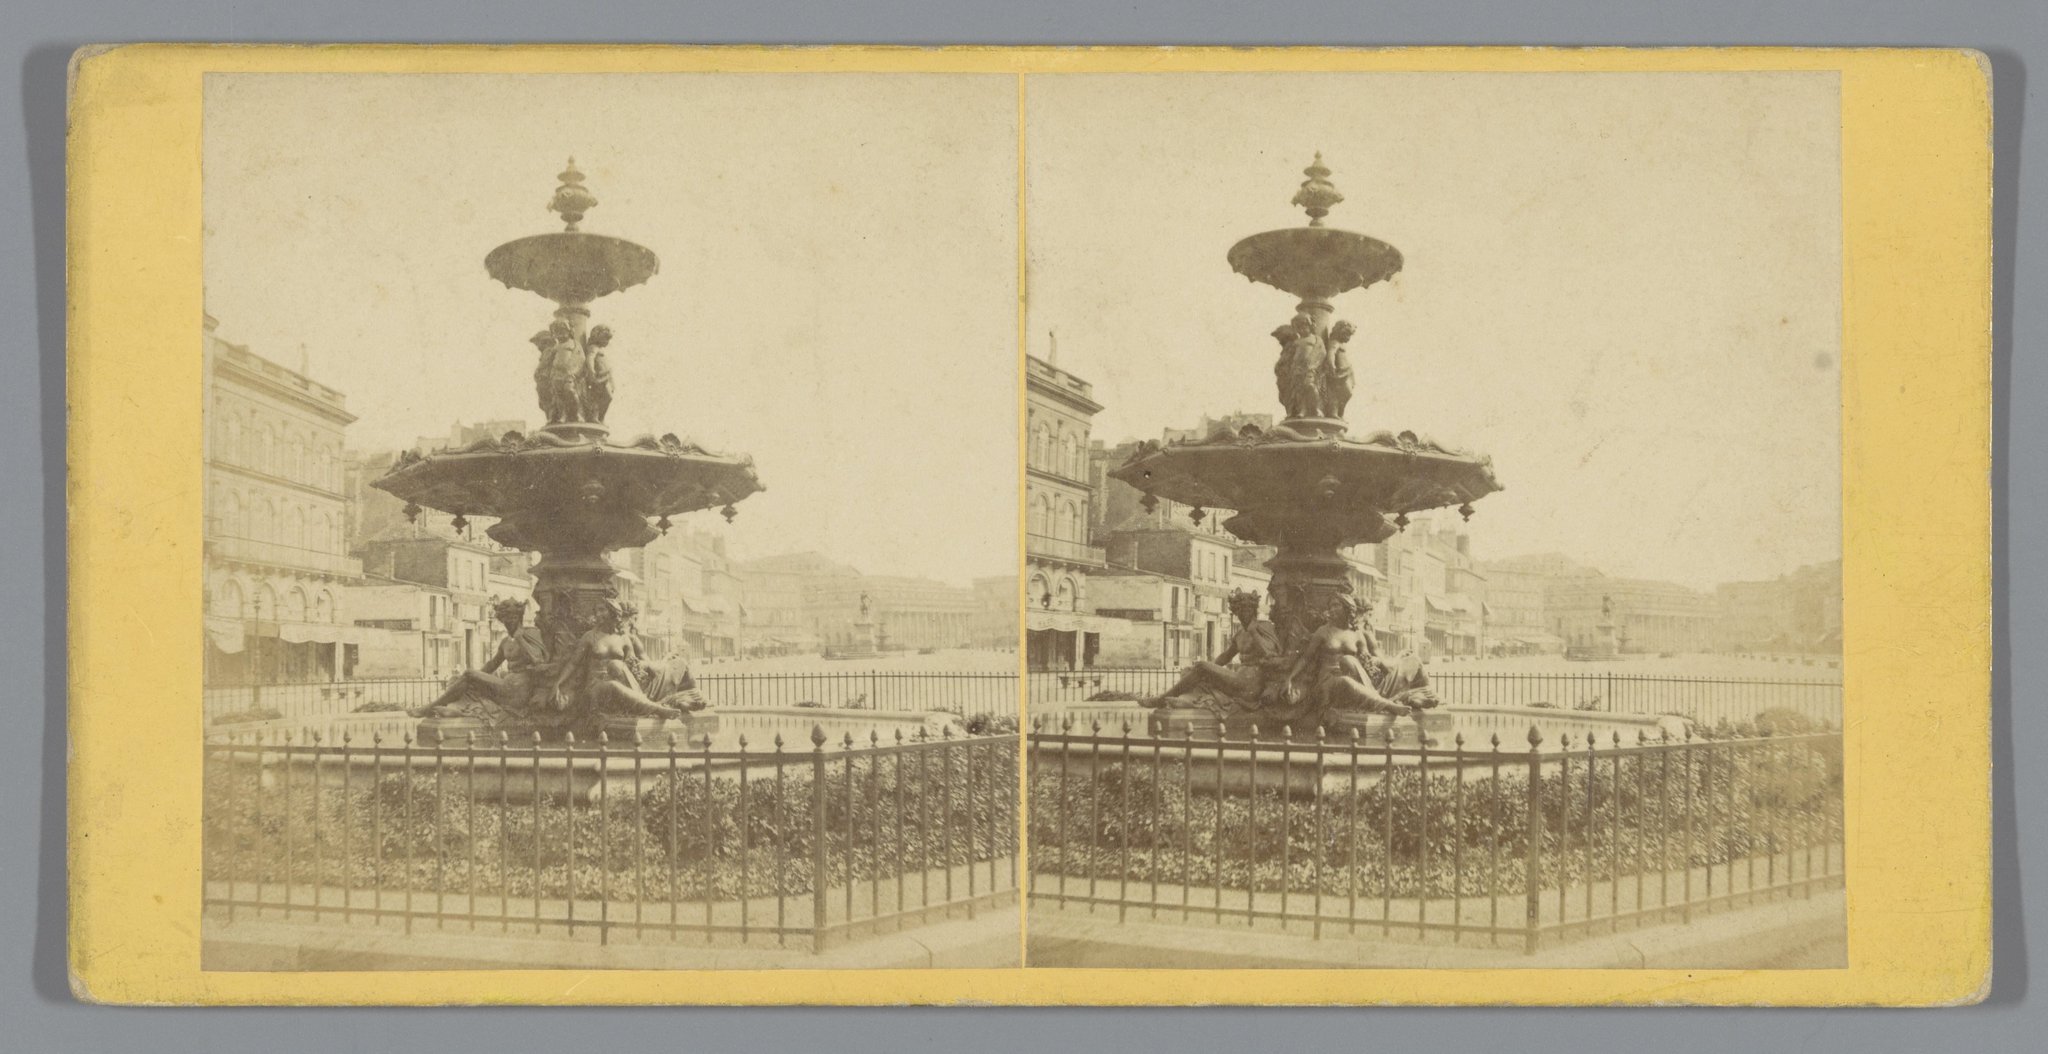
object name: stereograph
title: Fontaines de Tourny (Bordeaux)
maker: Anonymous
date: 1860-1880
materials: cardboard, photographic support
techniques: albumen print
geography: bordeaux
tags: ornamental fountain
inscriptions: number: ‘238.’